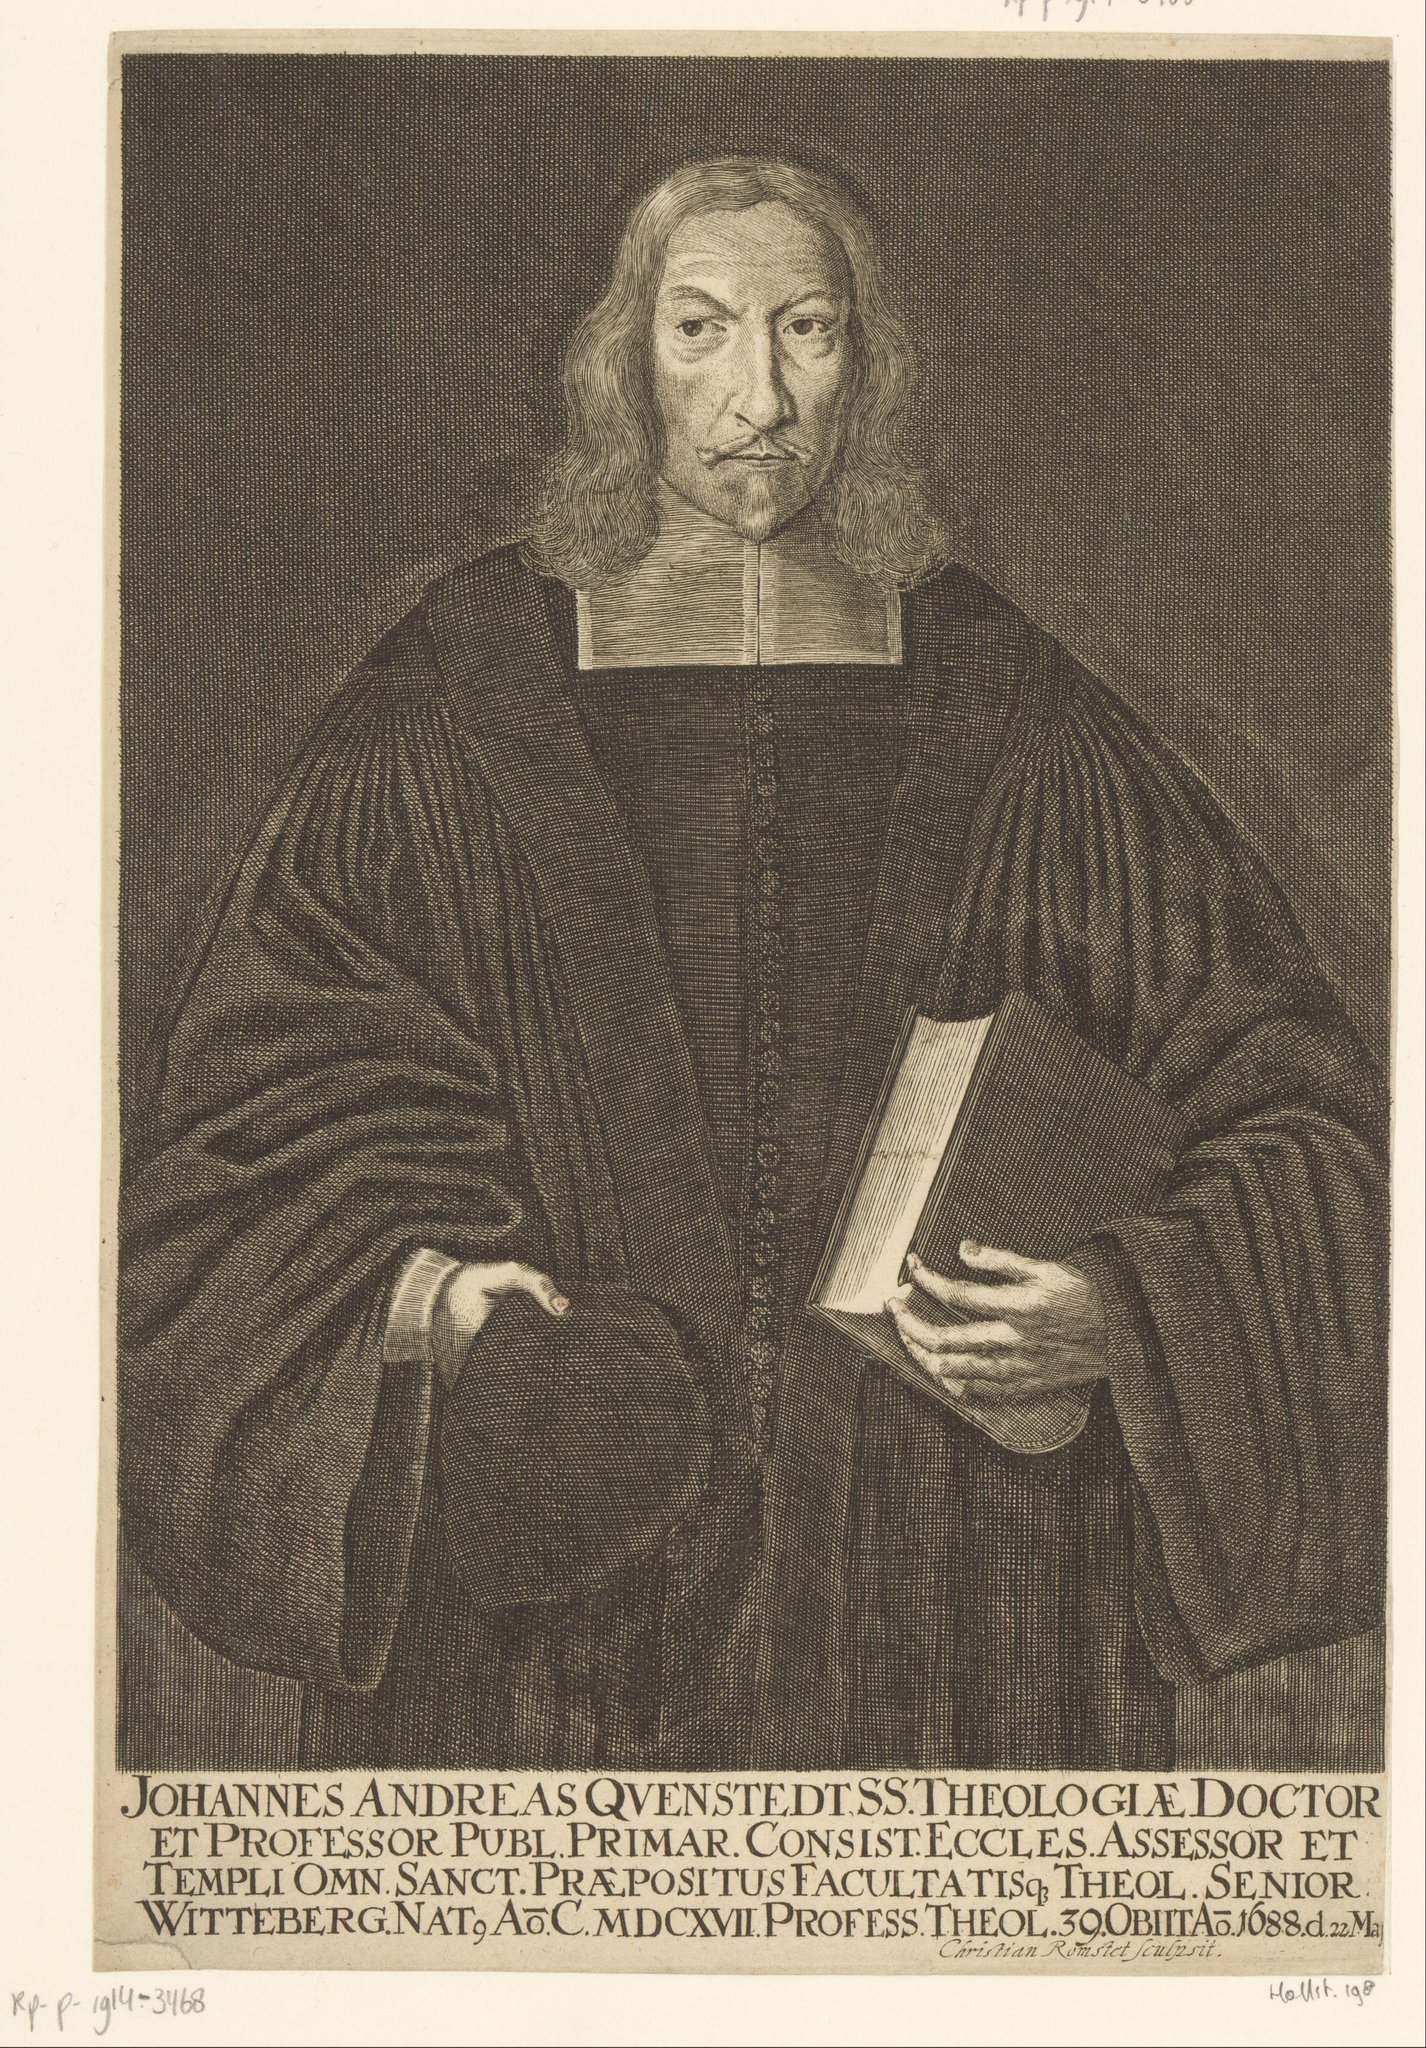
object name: print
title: Portret van Johann Andreas Quenstedt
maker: christian romstet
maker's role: print maker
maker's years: 1640-1721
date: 1688-1721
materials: paper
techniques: engraving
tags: theologian, historical persons, book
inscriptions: collector's mark: Lugt 2228